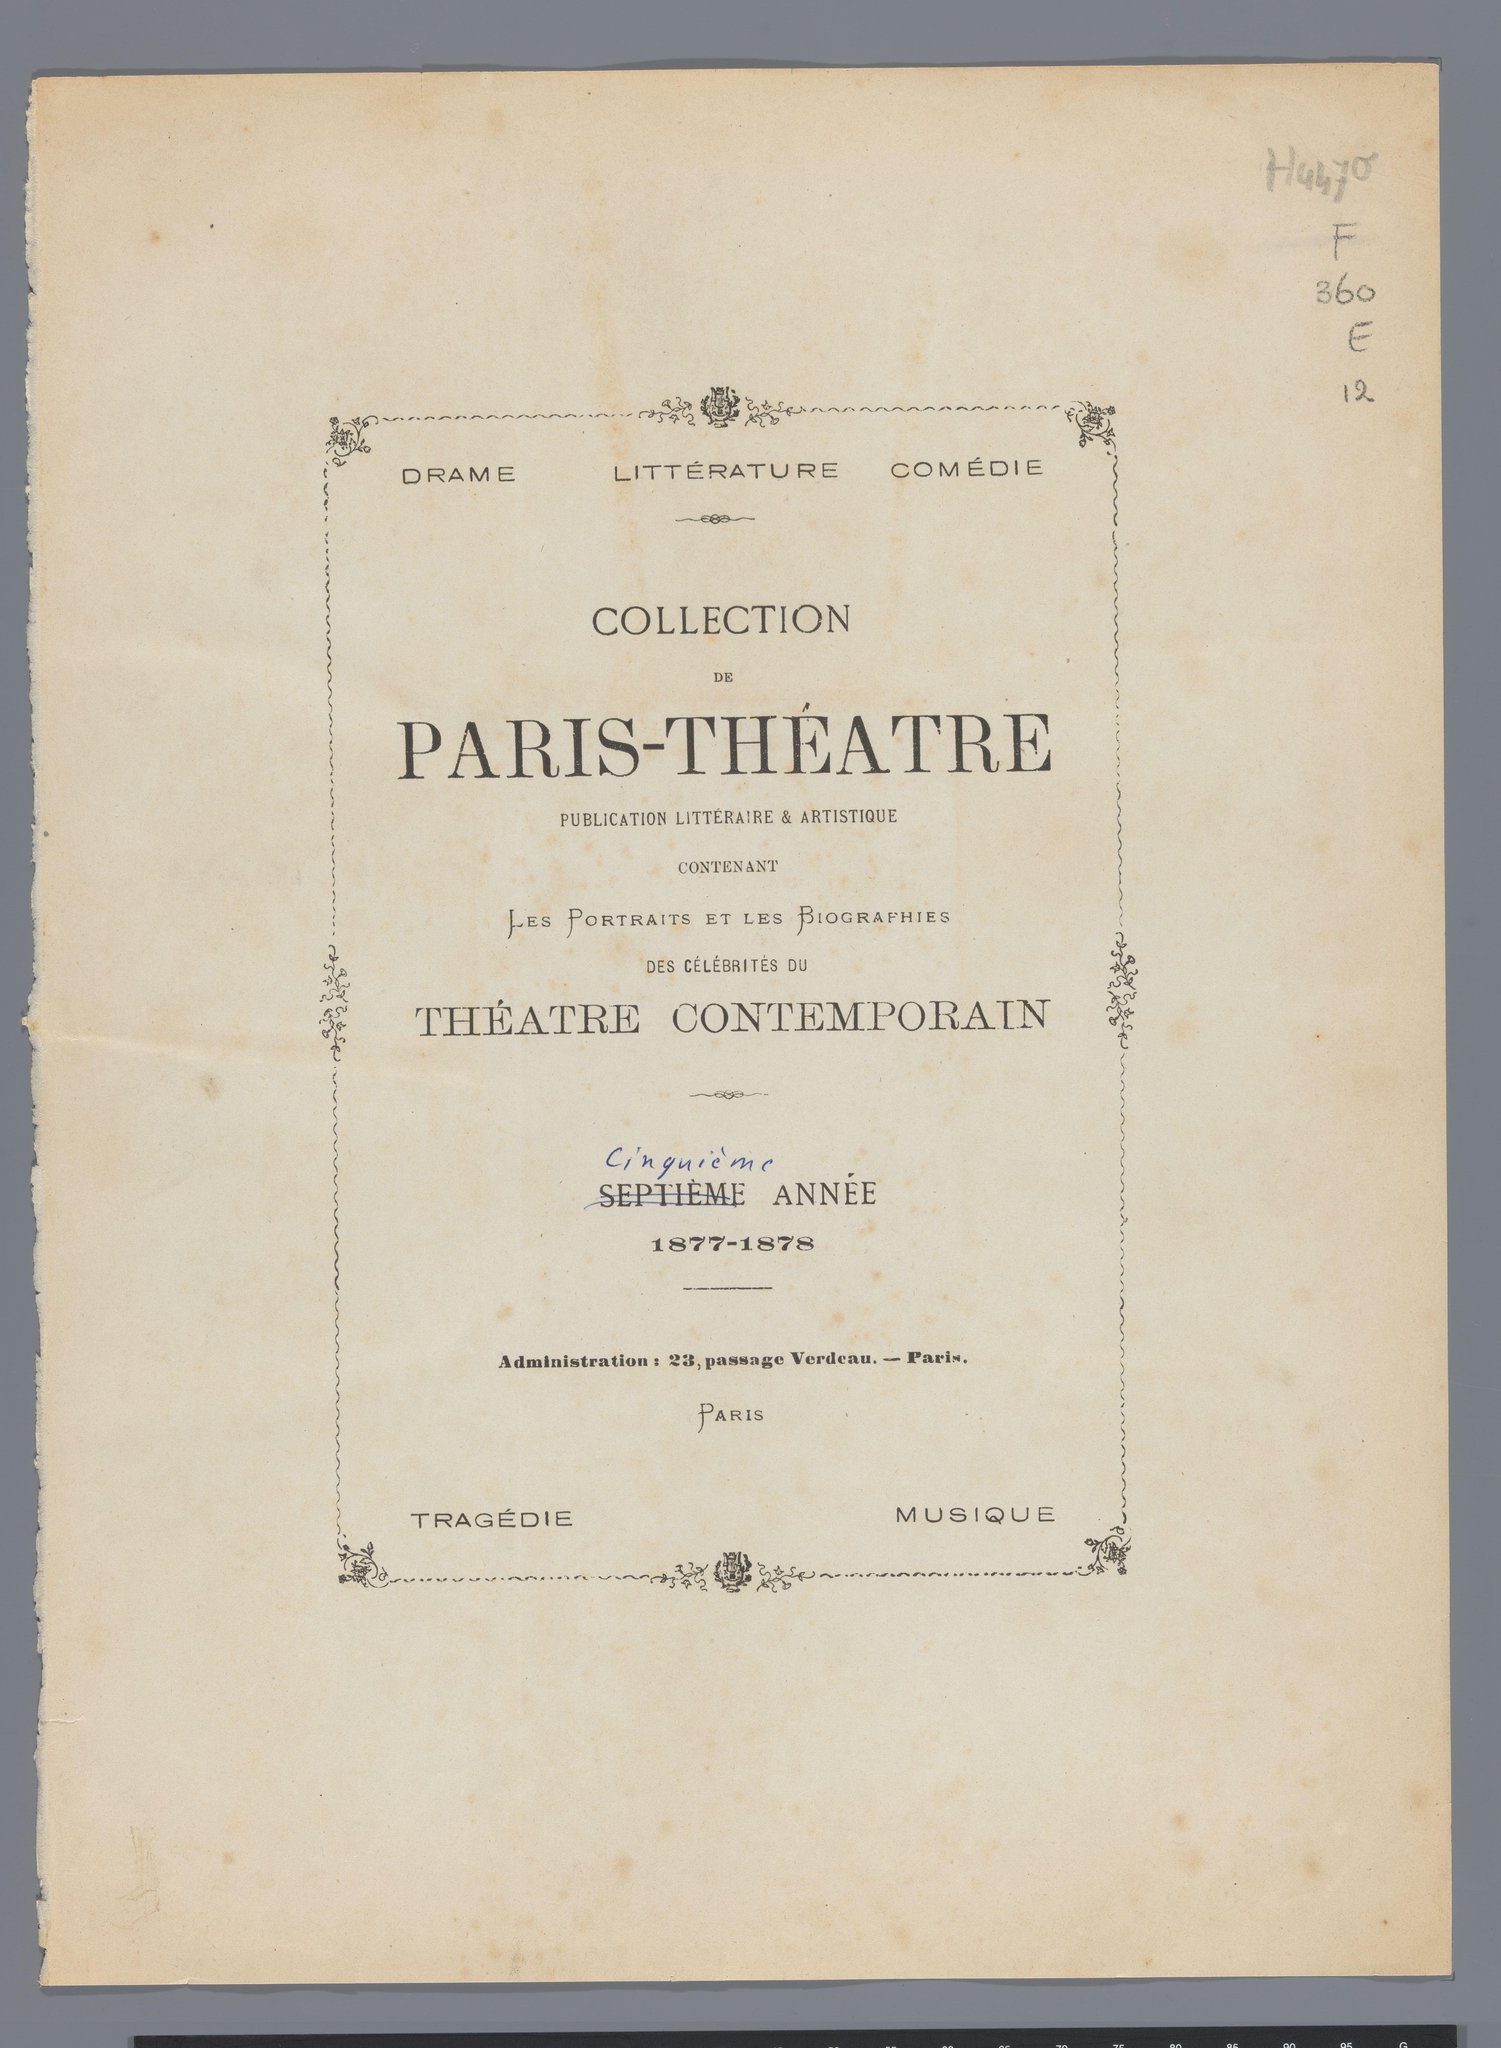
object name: wrapper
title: Paris-Portrait : ancien Paris-Theatre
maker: eugène paz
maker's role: journalist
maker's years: 1835-1901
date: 1878-1880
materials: cardboard, paper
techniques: printing, woodburytype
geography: paris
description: Omslag met zowel Paris-Portrait en Ancien Paris-Theatre.